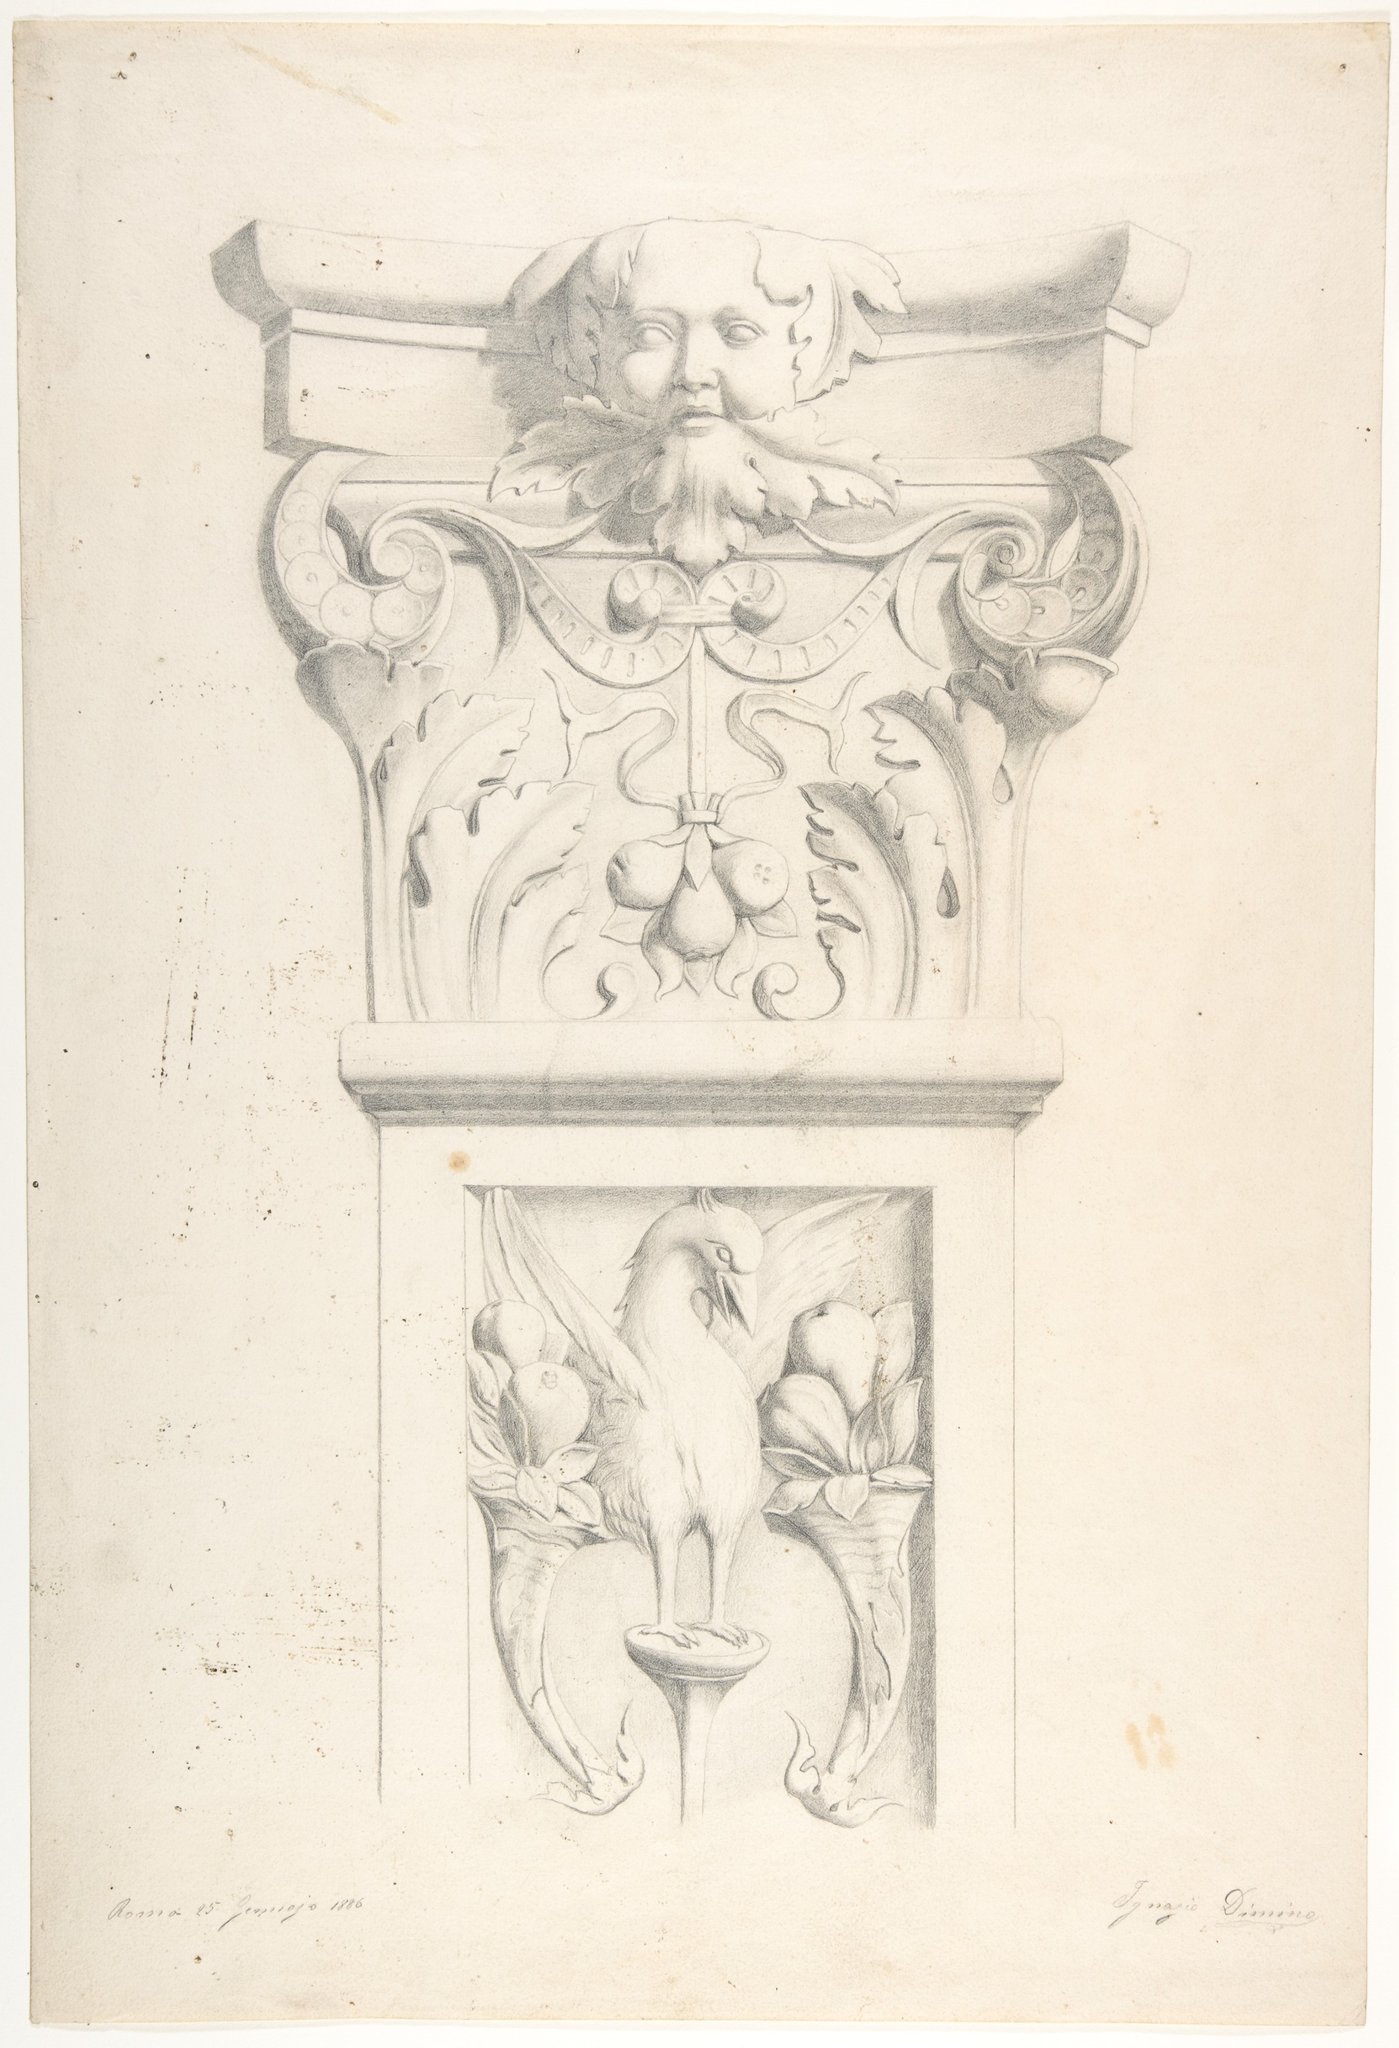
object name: drawing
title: Drawing after a XVIth-Century Marble Pilaster and Capital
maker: ignazio dimino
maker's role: artist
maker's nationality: italian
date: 1886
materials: graphite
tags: capitals